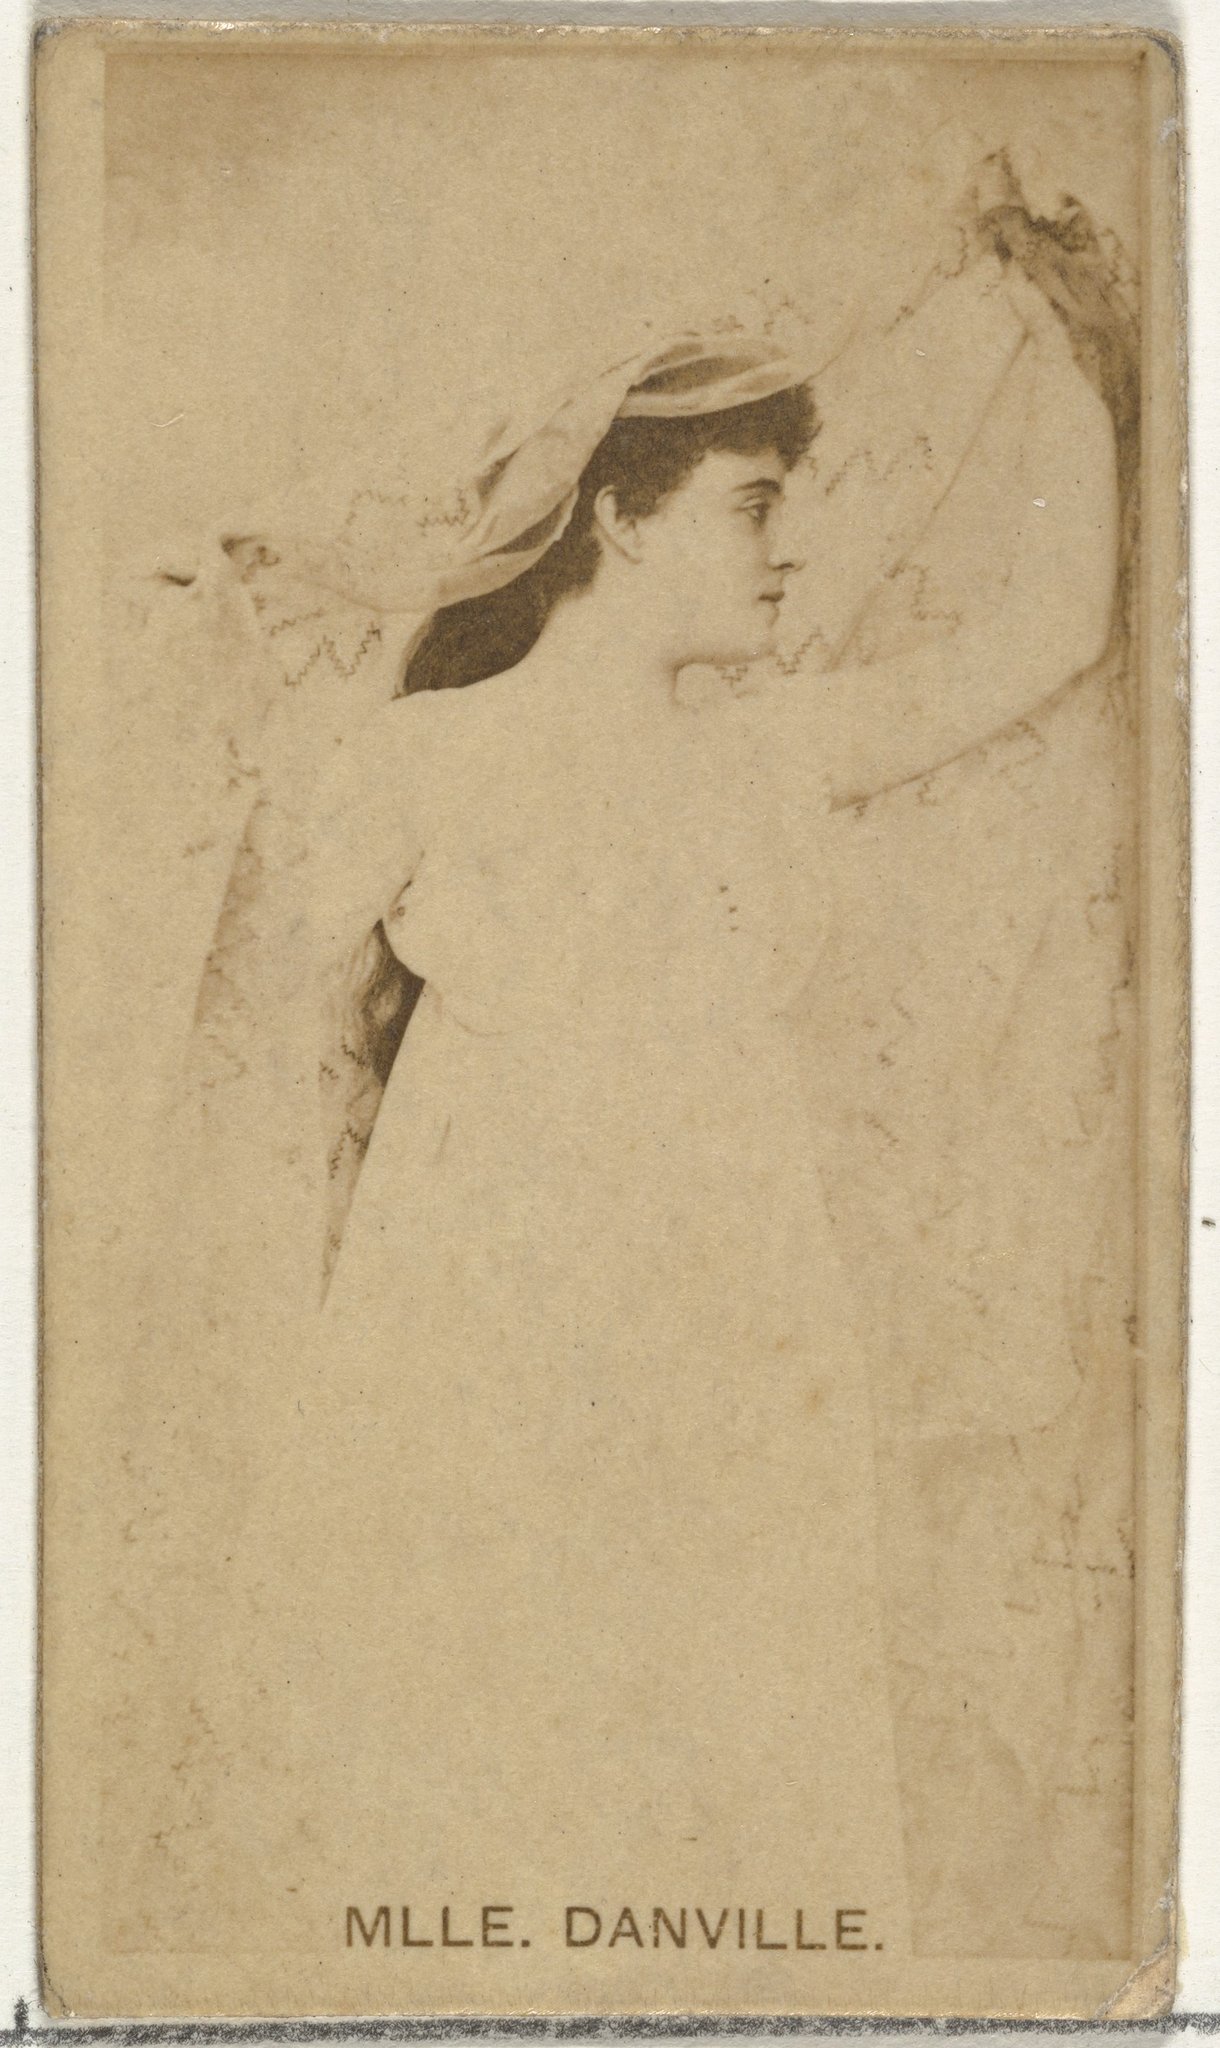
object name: photograph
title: Mlle. Danville, from the Actors and Actresses series (N145-8) issued by Duke Sons & Co. to promote Duke Cigarettes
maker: w. duke, sons & co.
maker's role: publisher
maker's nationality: american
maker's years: 1870-1920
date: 1891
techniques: albumen silver print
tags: portraits,women,actresses